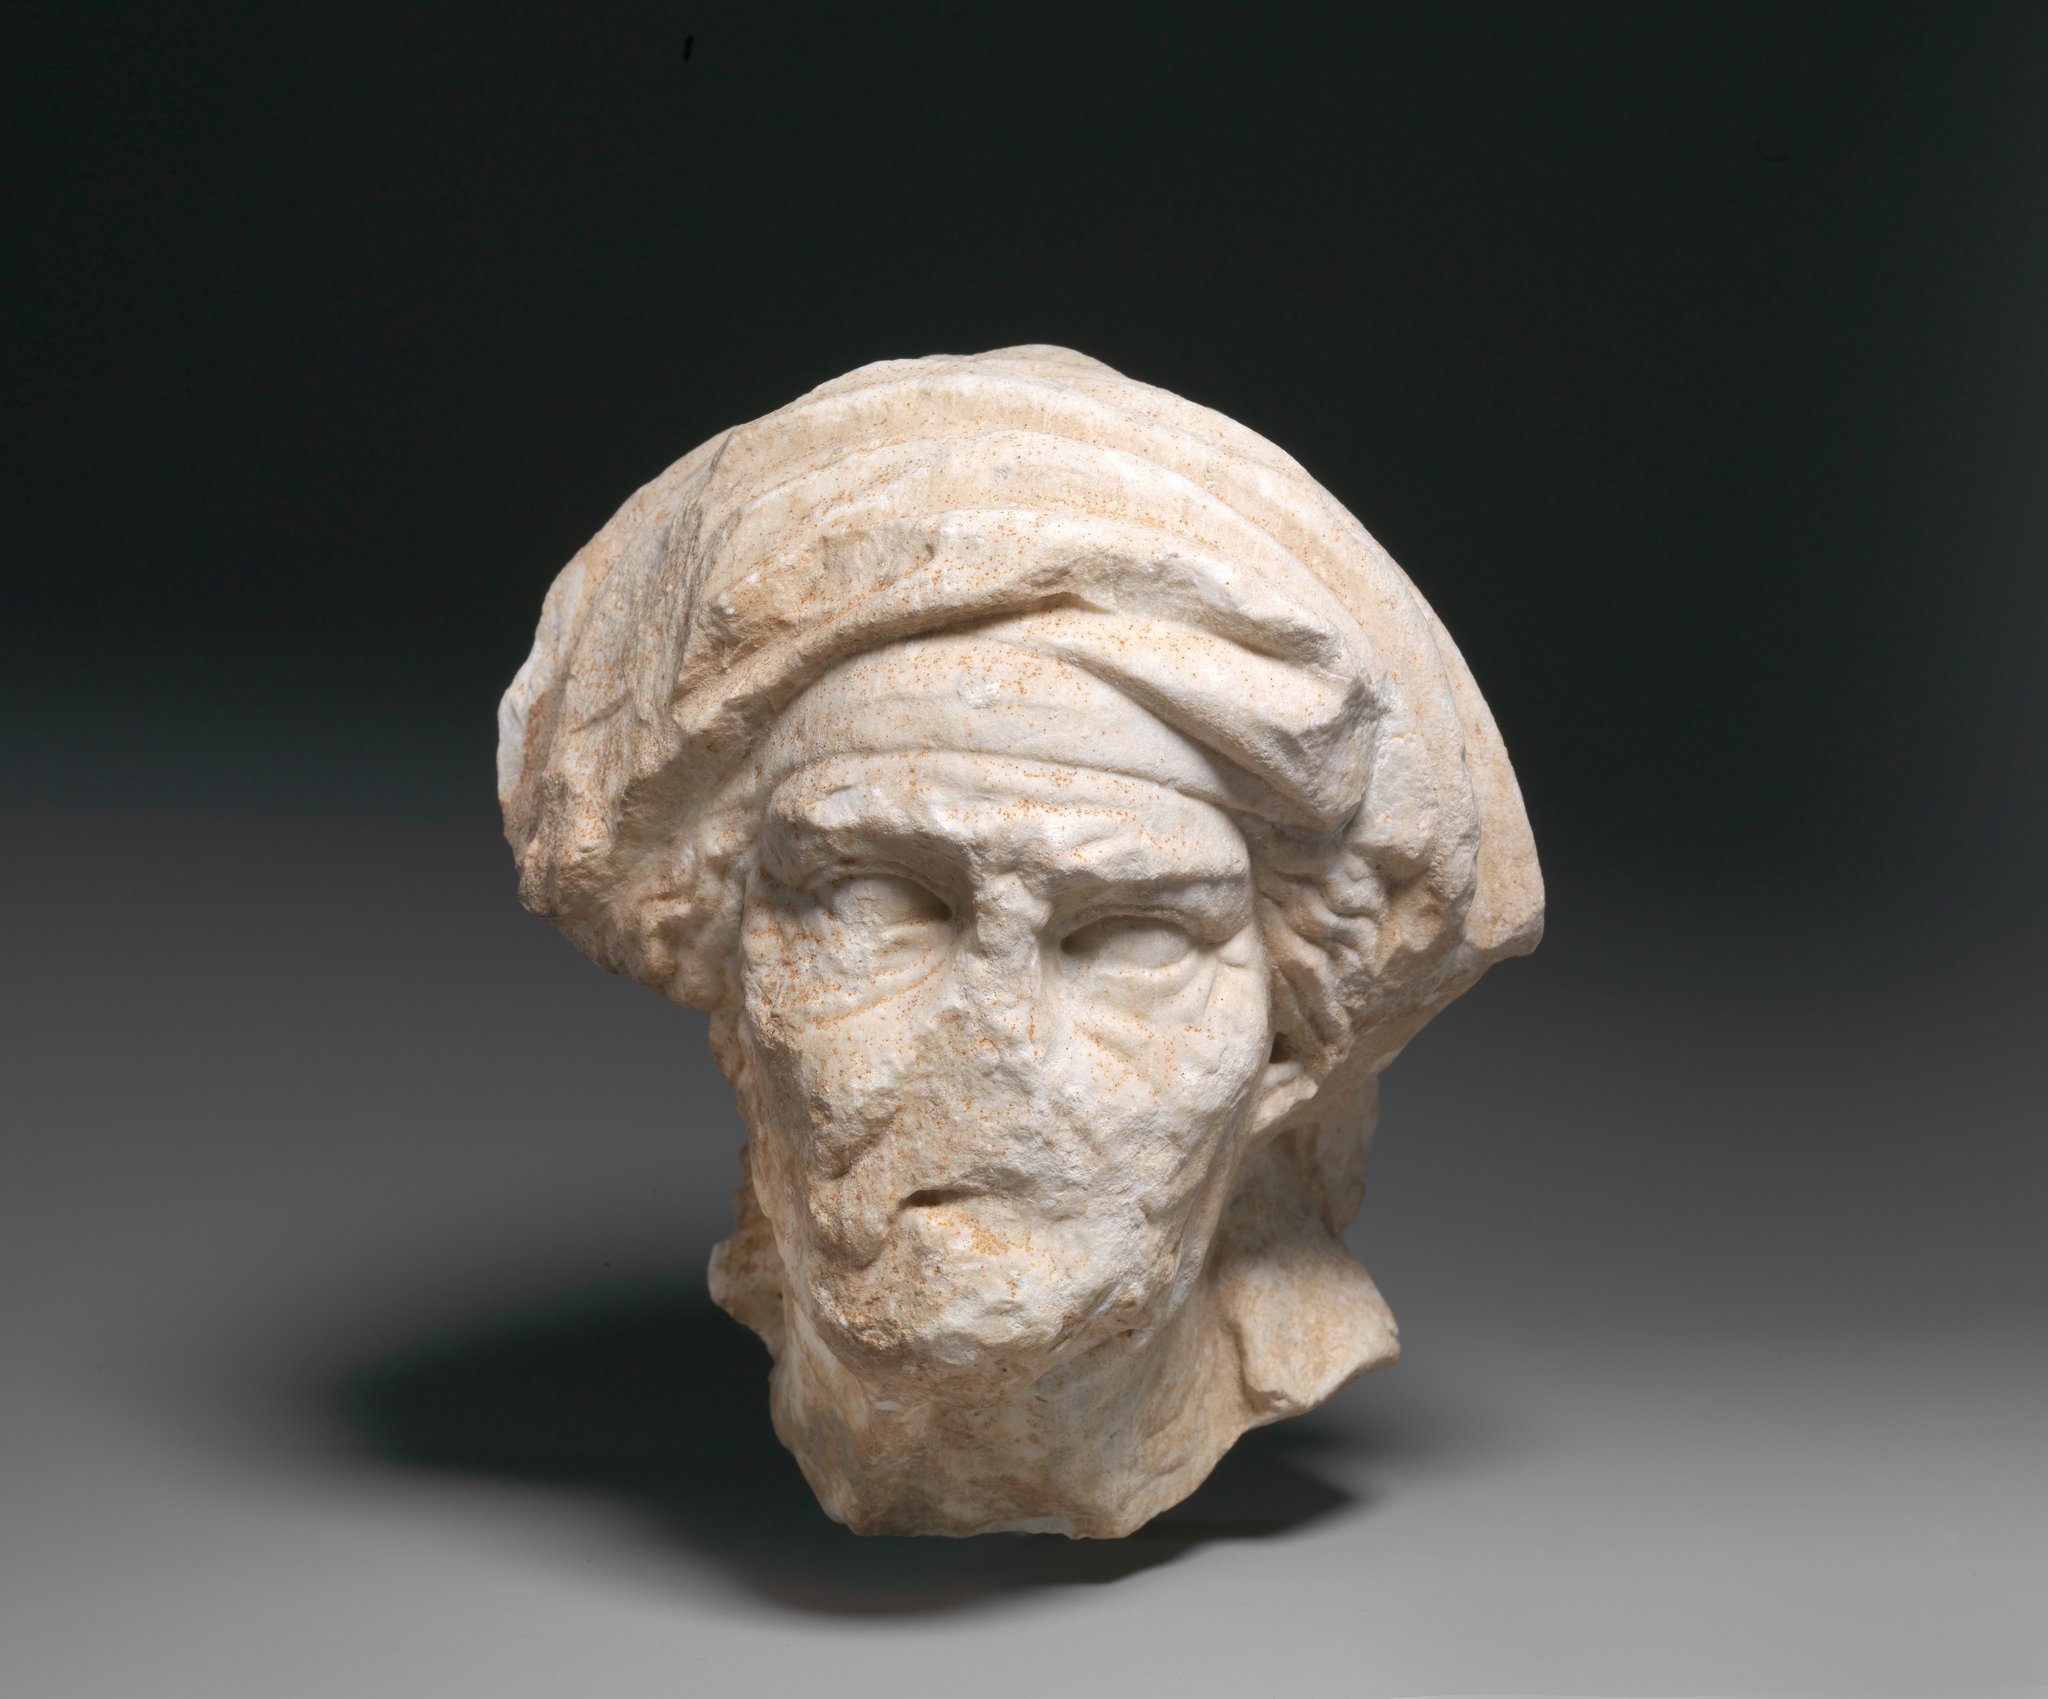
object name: head of an old woman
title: Marble head of an old woman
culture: roman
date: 1-100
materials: marble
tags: heads,women